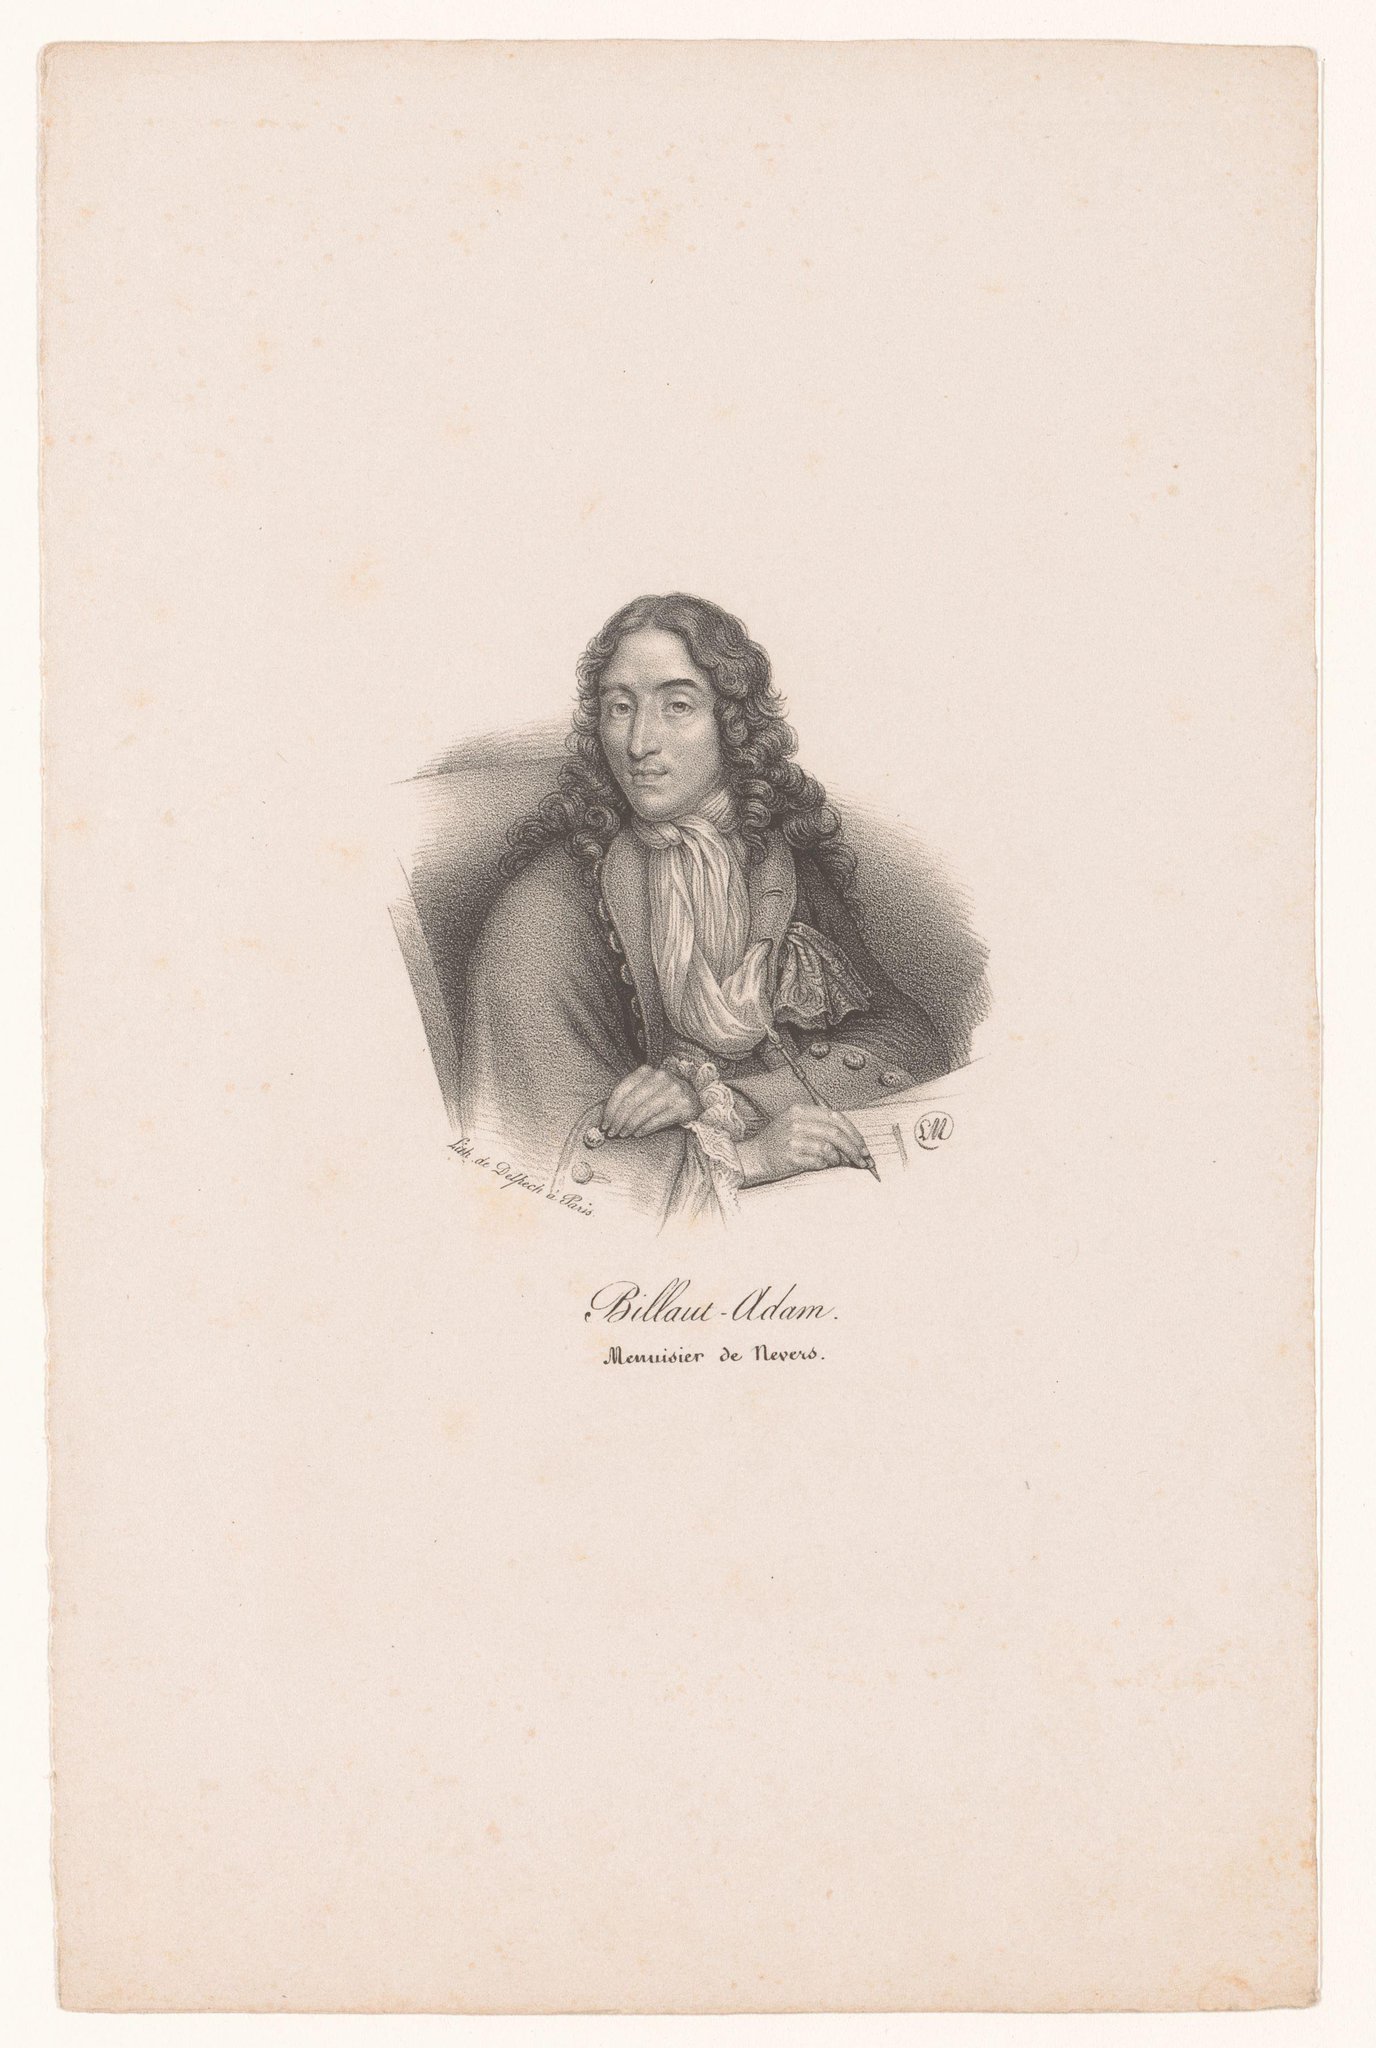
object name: print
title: Billaut-Adam. Menuisier de Nevers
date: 1825-1842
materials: paper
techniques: lithograph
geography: paris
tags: historical persons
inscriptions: collector's mark: Lugt 2228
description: Prent waarschijnlijk gebruikt voor: Iconographie française ou recueil des portraits des personnages les plus illustres qui ont paru en France depuis François premier jusqu'à la fin du règne de Louis XVI (…). Parijs: veuve Delpech, 1828. En/of voor: Iconographie française ou choix de deux cents portraits d'hommes et de femmes qui se sont acquis en France, depuis le règne de Charles VII jusqu'à la fin de celui de Louis XVI (…). Parijs: veuve Delpech, 1840. Mogelijk komt de prent ook voor in eerdere en/of latere publicaties uitgegeven door veuve Delpech of haar opvolger Rosselin.